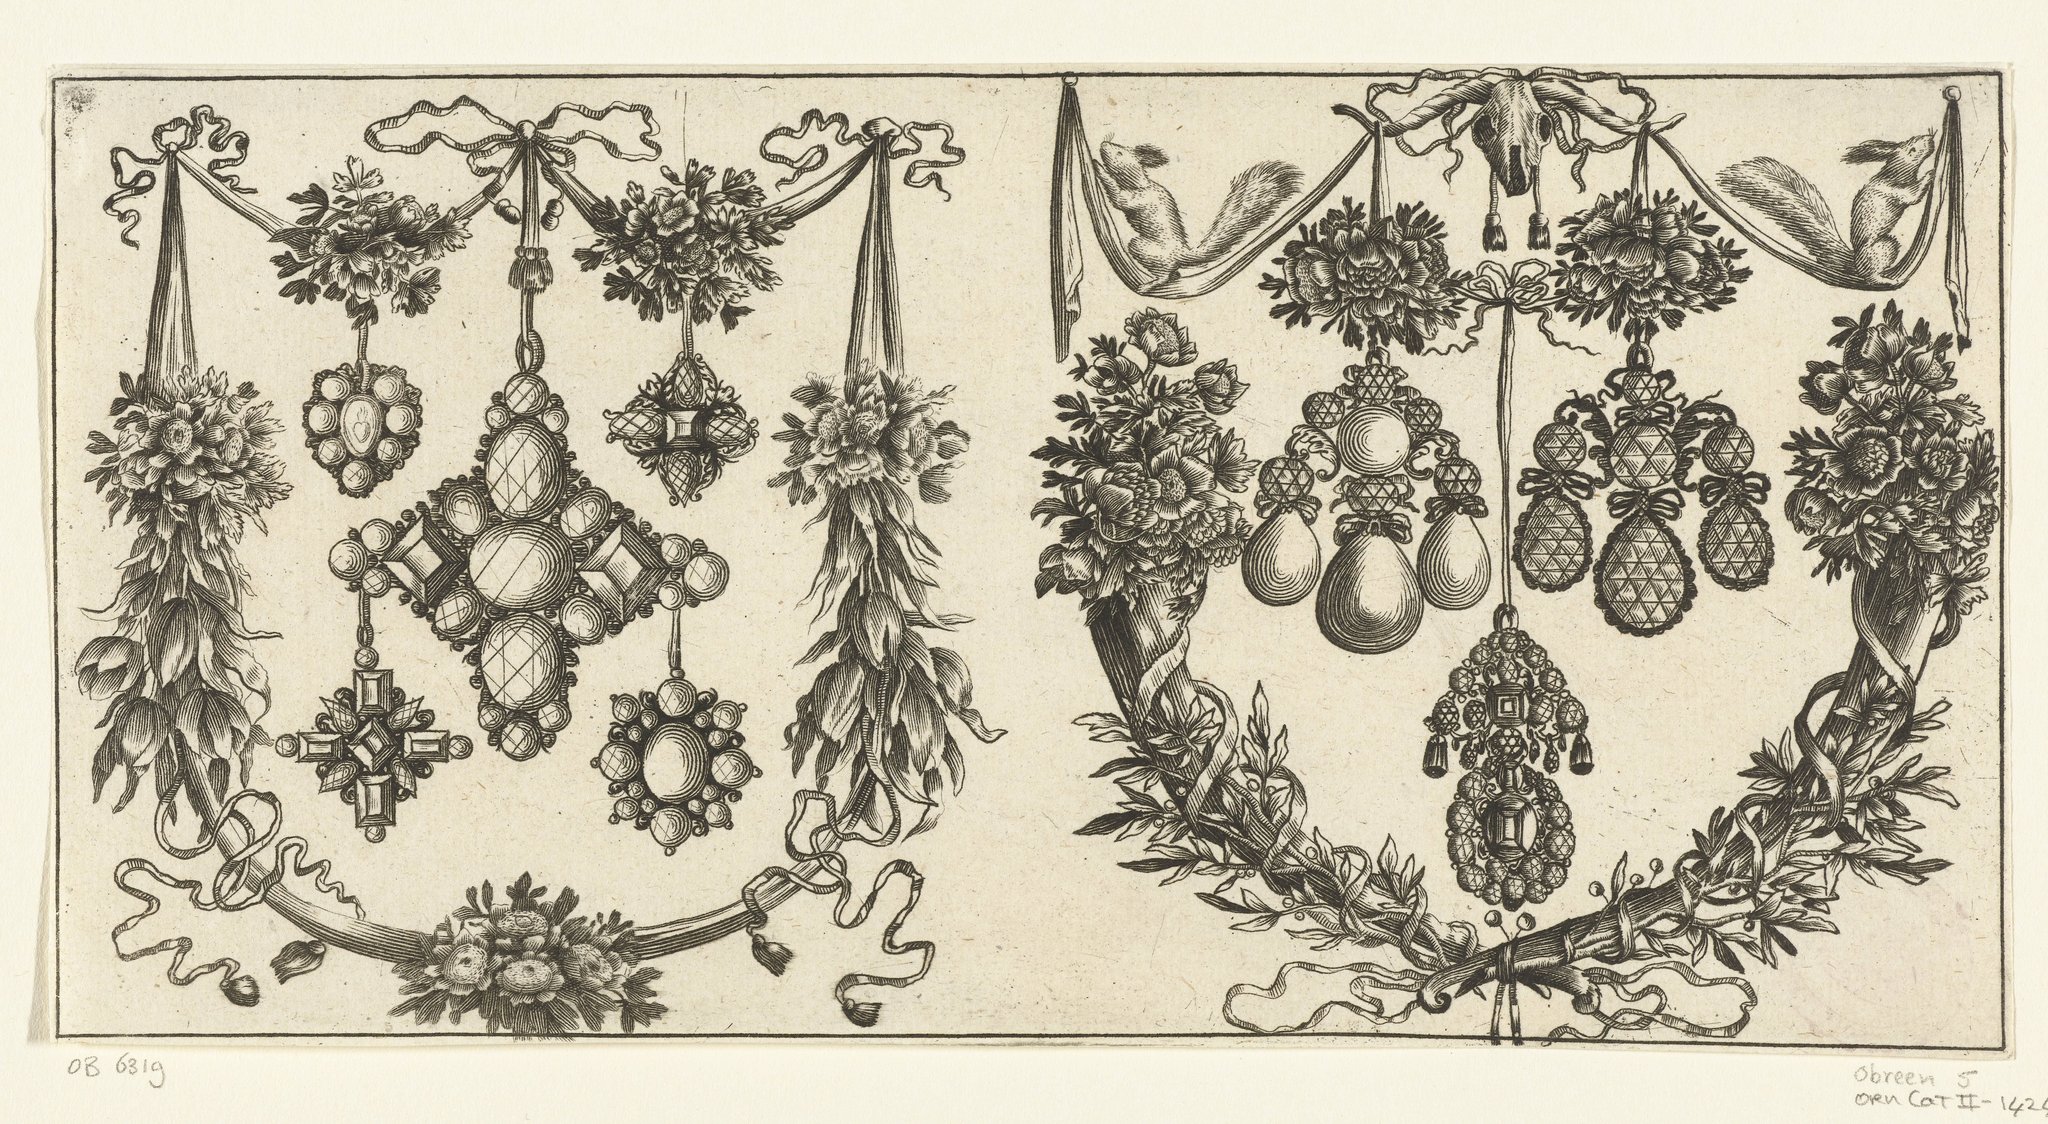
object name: print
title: Nieuw Goutsmits Boeck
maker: daniel de lafeuille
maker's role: print maker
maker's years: 1640-1709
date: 1650-1709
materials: paper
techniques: engraving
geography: amsterdam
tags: hare-hunting, rabbit-hunting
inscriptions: collector's mark: Lugt 240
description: Tegenzijdige kopieën naar ontwerpen van François Lefebvre: links naar RP-P-1961-90, rechts naar RP-P-1961-88. Uit serie bestaande uit een titelblad en 4 bladen, elk met ontwerpen voor juwelen in een ornamentele rand van festons, bladeren, bloemen en hoorns des overvloeds.